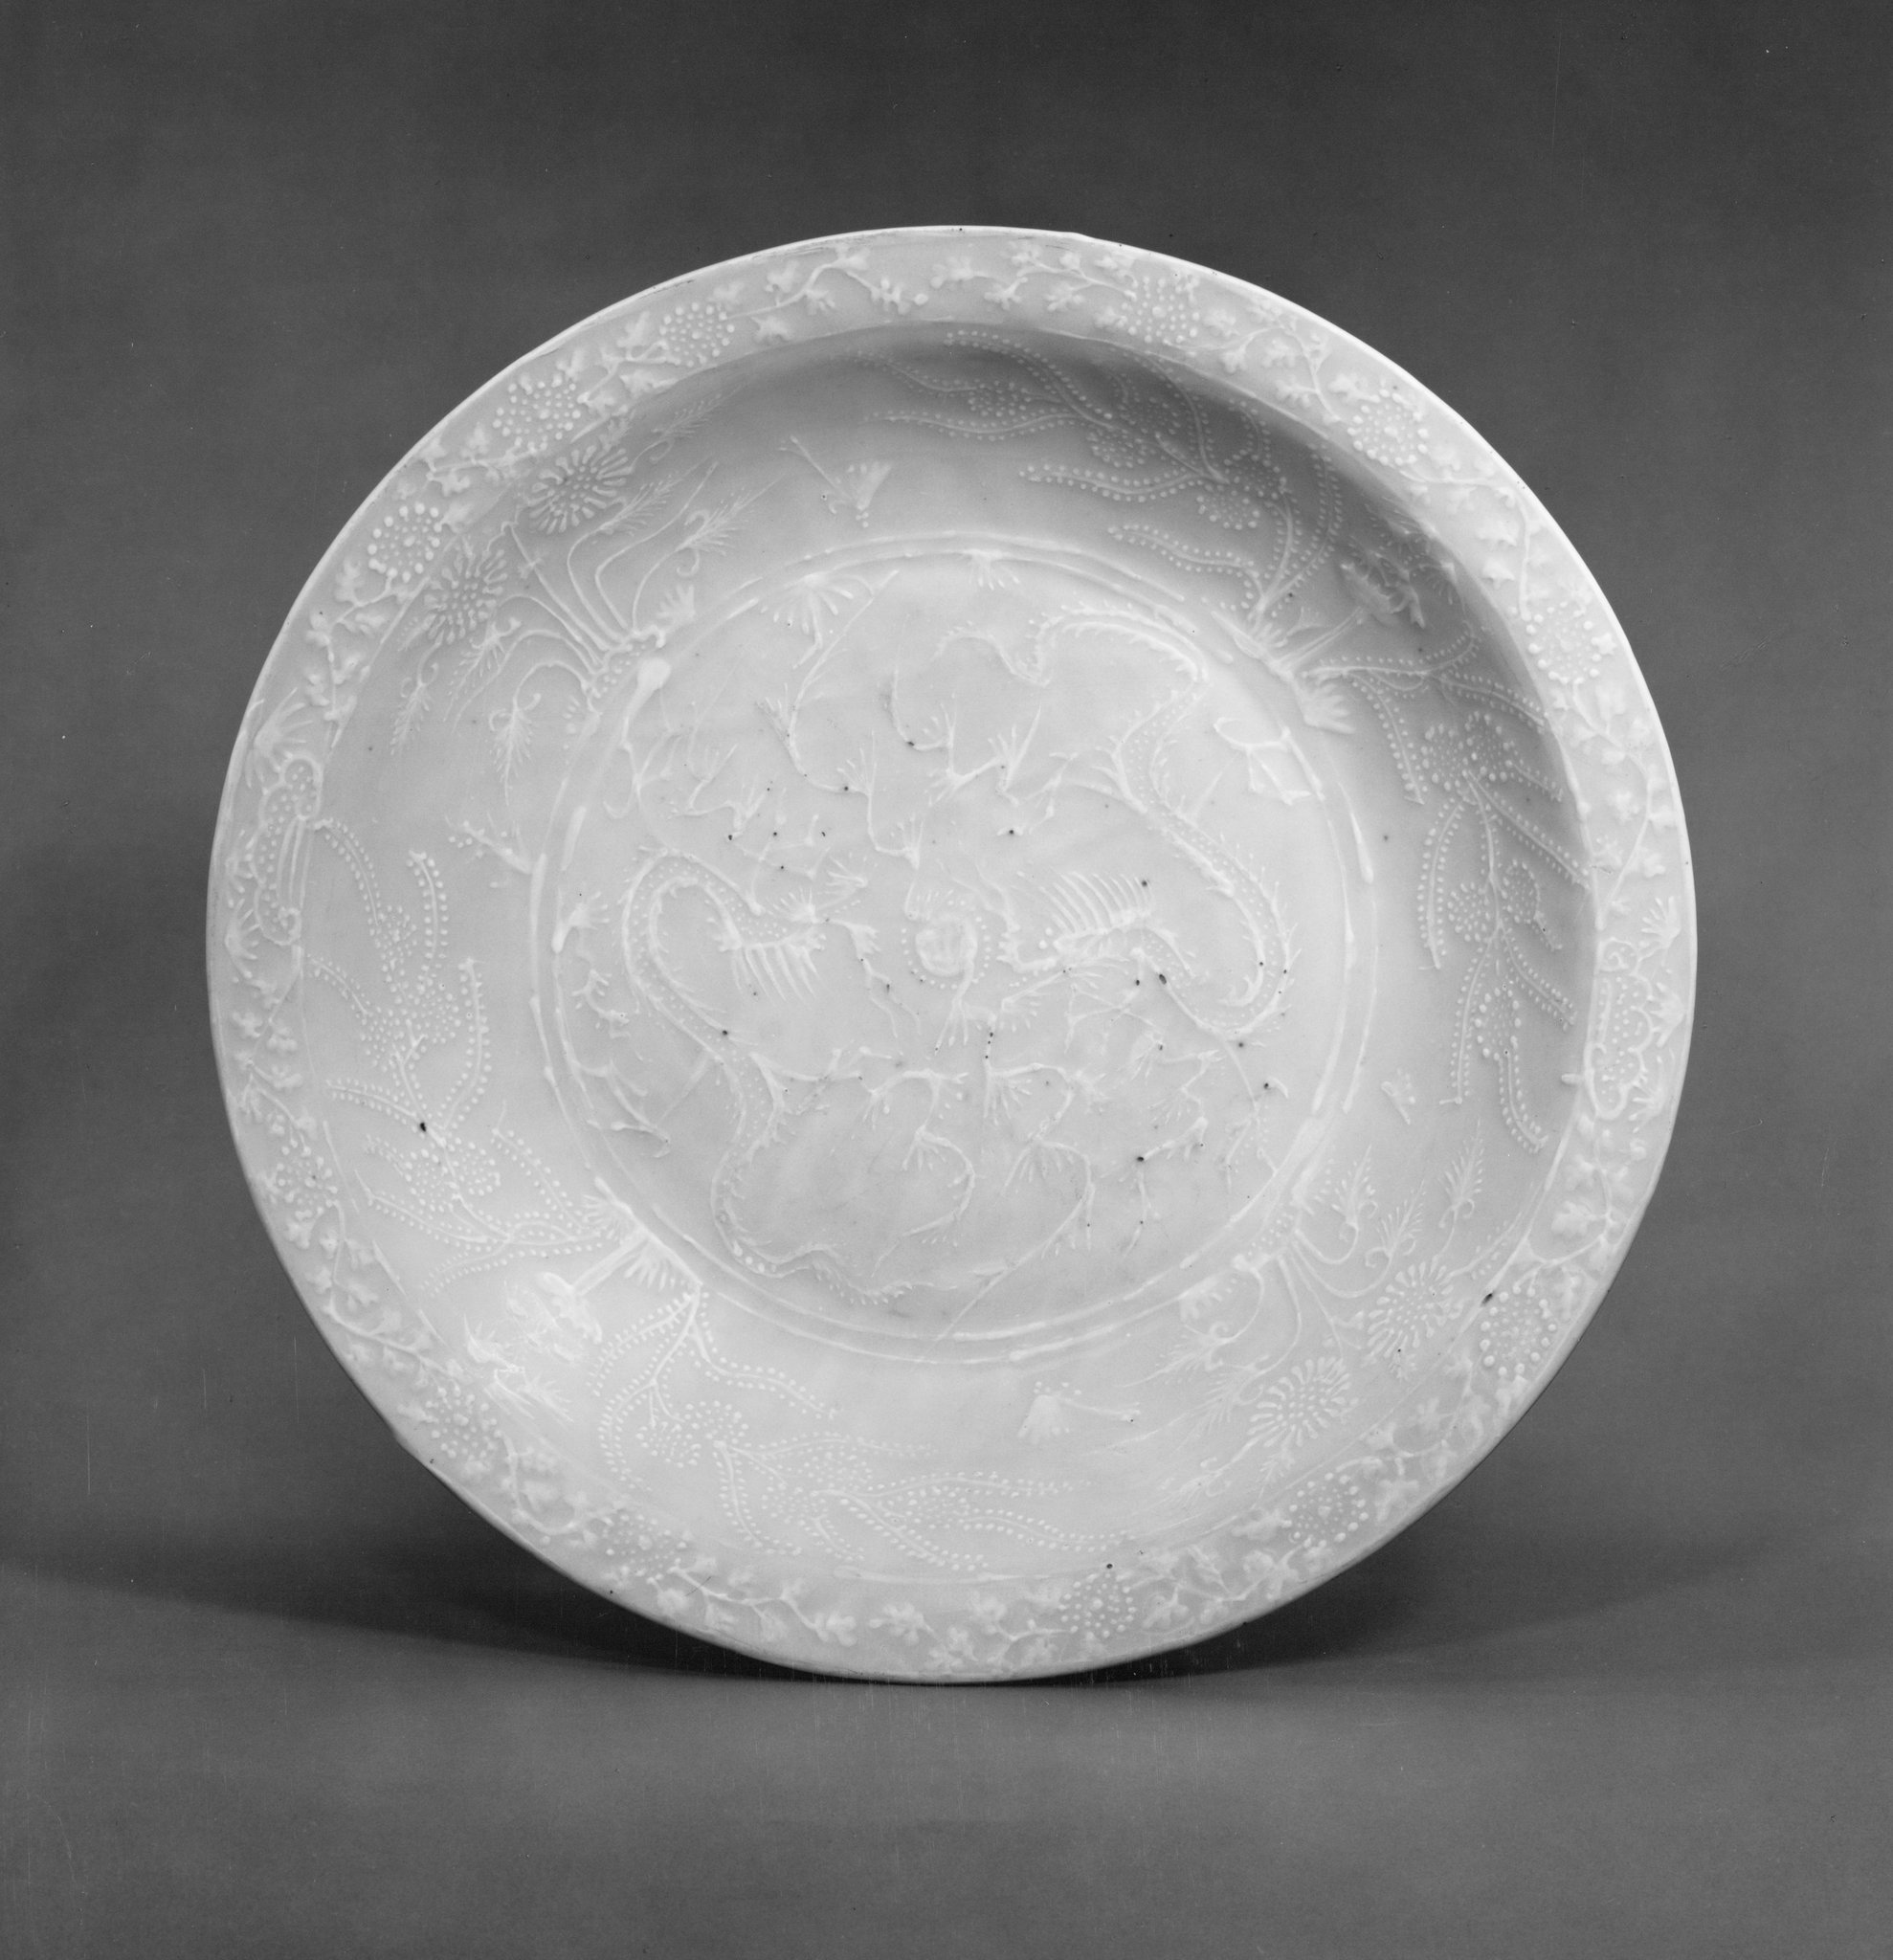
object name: plate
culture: chinese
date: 1567-1633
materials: ceramic glaze, glaze, stoneware